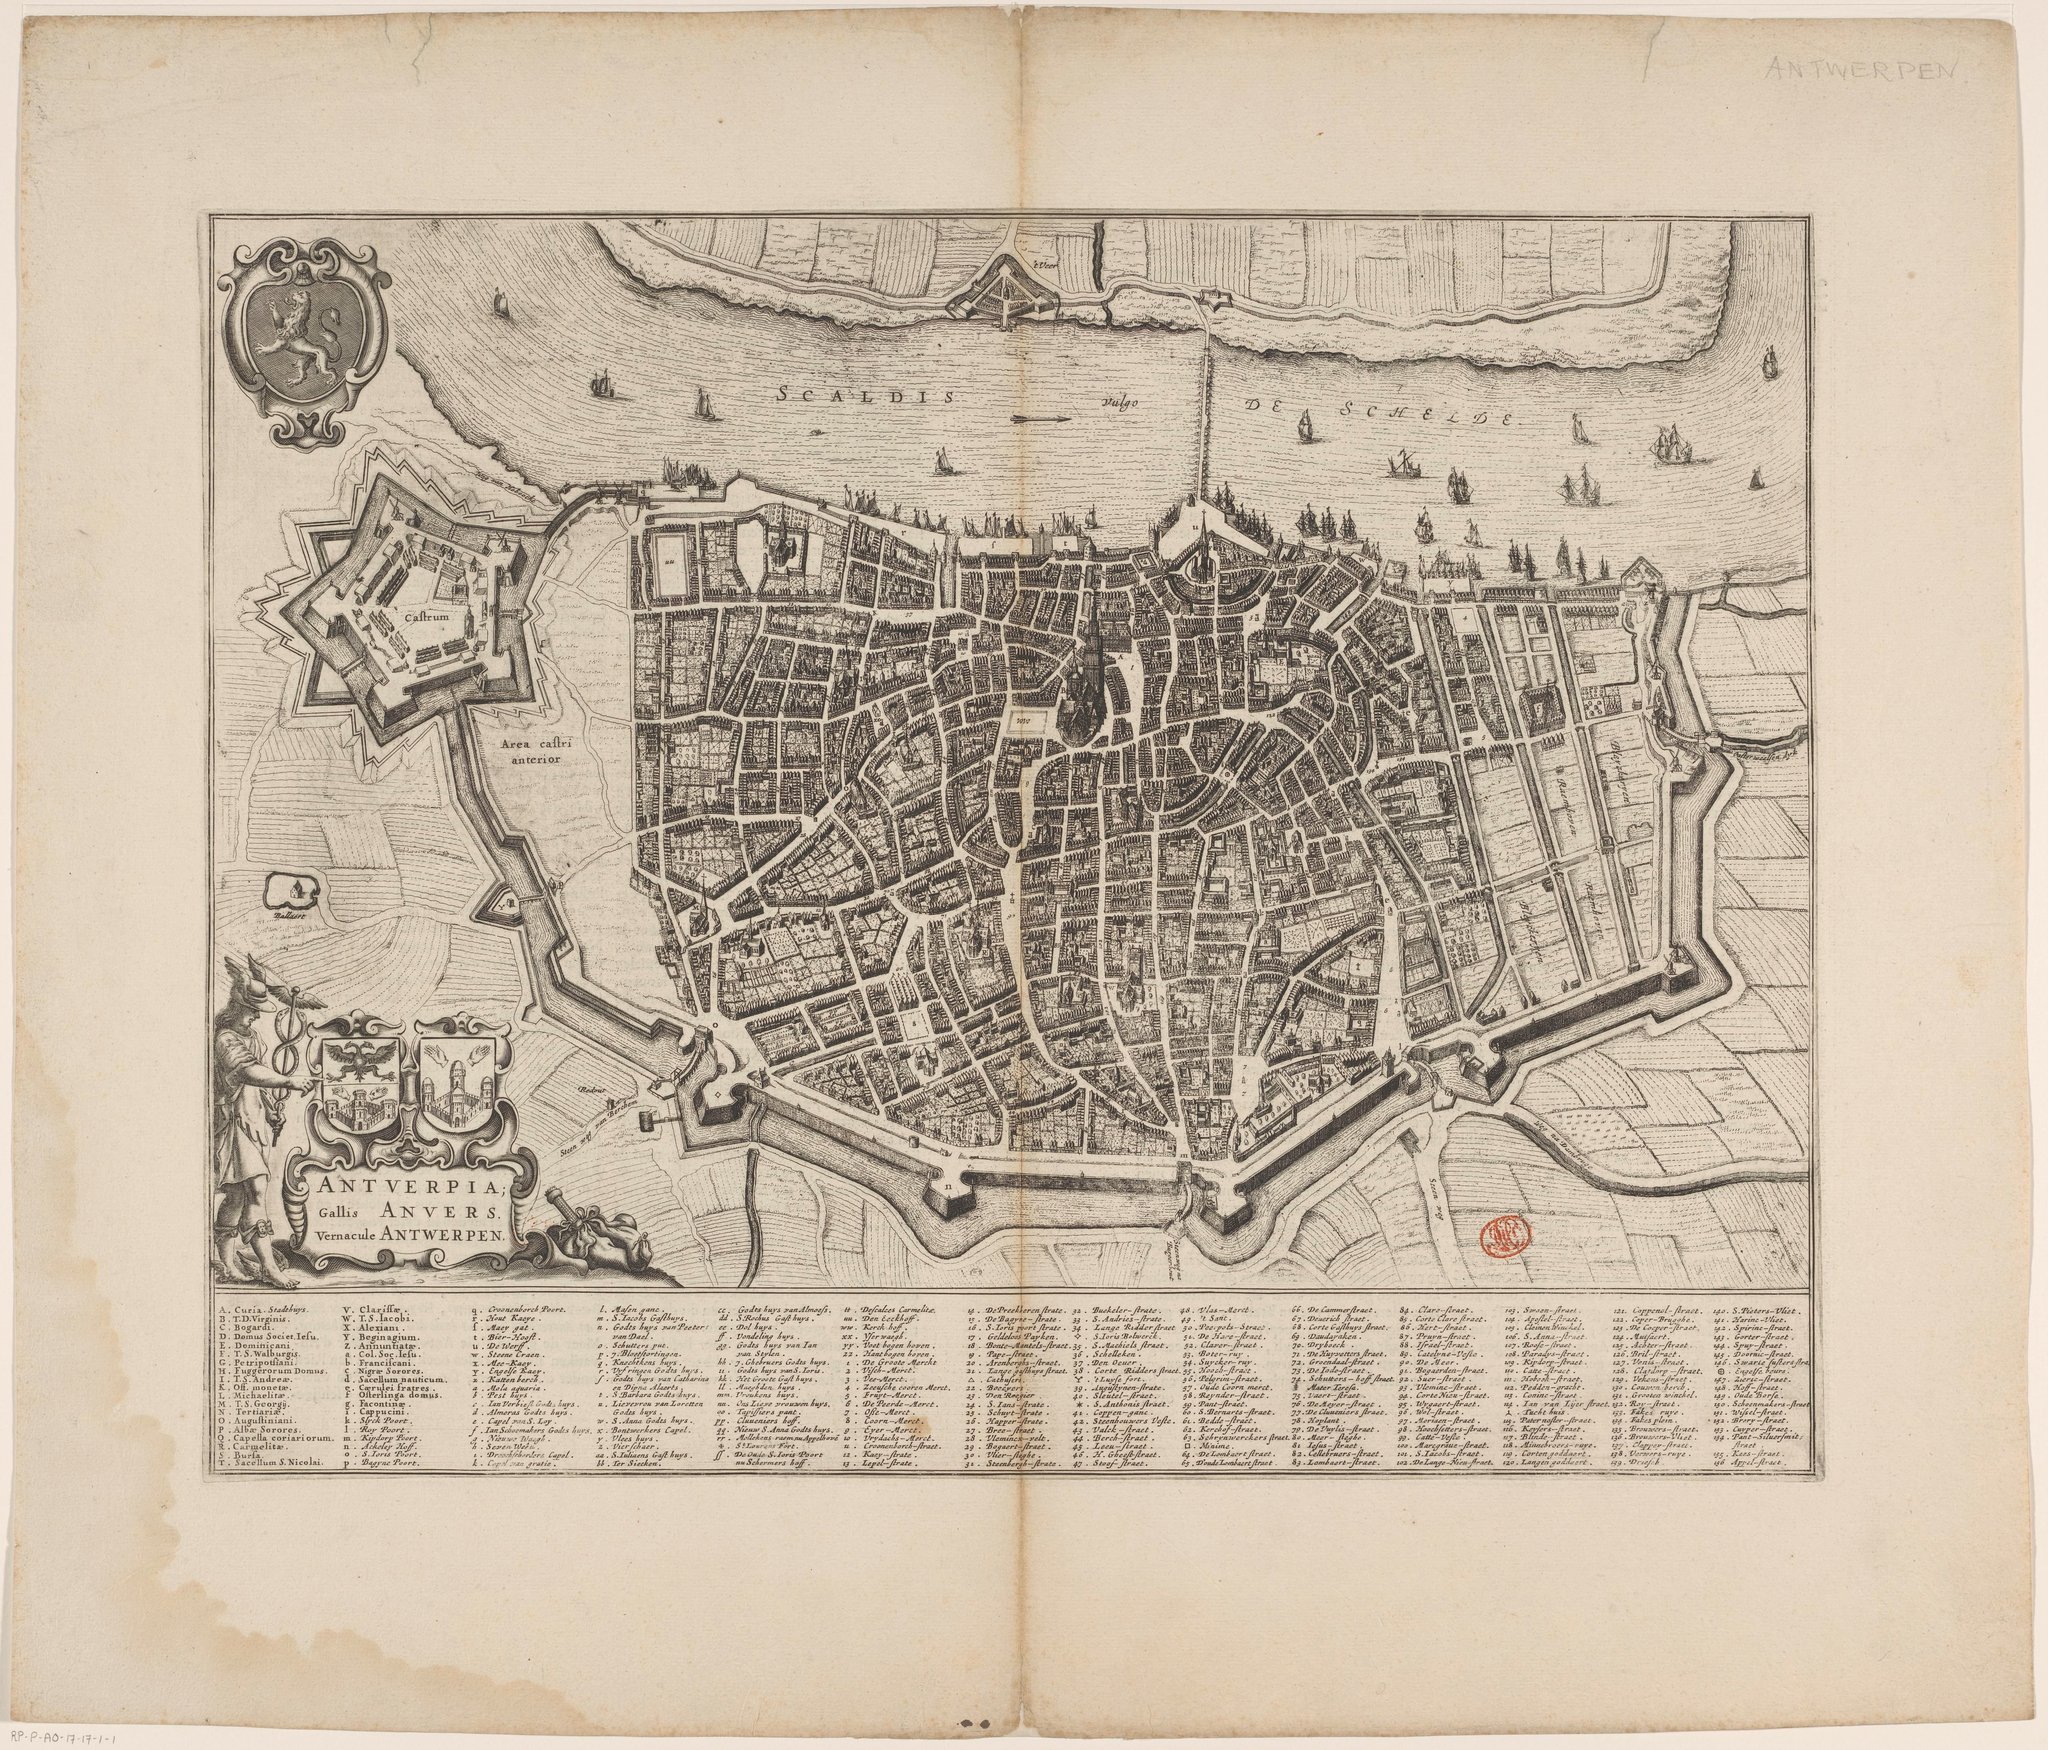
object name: print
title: Plattegrond van Antwerpen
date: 1652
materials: paper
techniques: engraving, etching, letterpress printing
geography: amsterdam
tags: coat of arms (as symbol of the state, etc.) (+ city; municipal), (story of) mercury (hermes), fortified city, maps of cities, coat of arms (as symbol of the state, etc.) (+ province; provincial), antwerp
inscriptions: collector's mark: Lugt 195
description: Plattegrond van Antwerpen met gebouwen in vogelvluchtperspectief. Linksonder de titelcartouche met twee wapens van Antwerpen. Linksboven het wapen van Brabant. In een balk onder de kaart een legenda A-Z, a-z, aa-zz en 1-156. Op verso Nederlandse tekst.